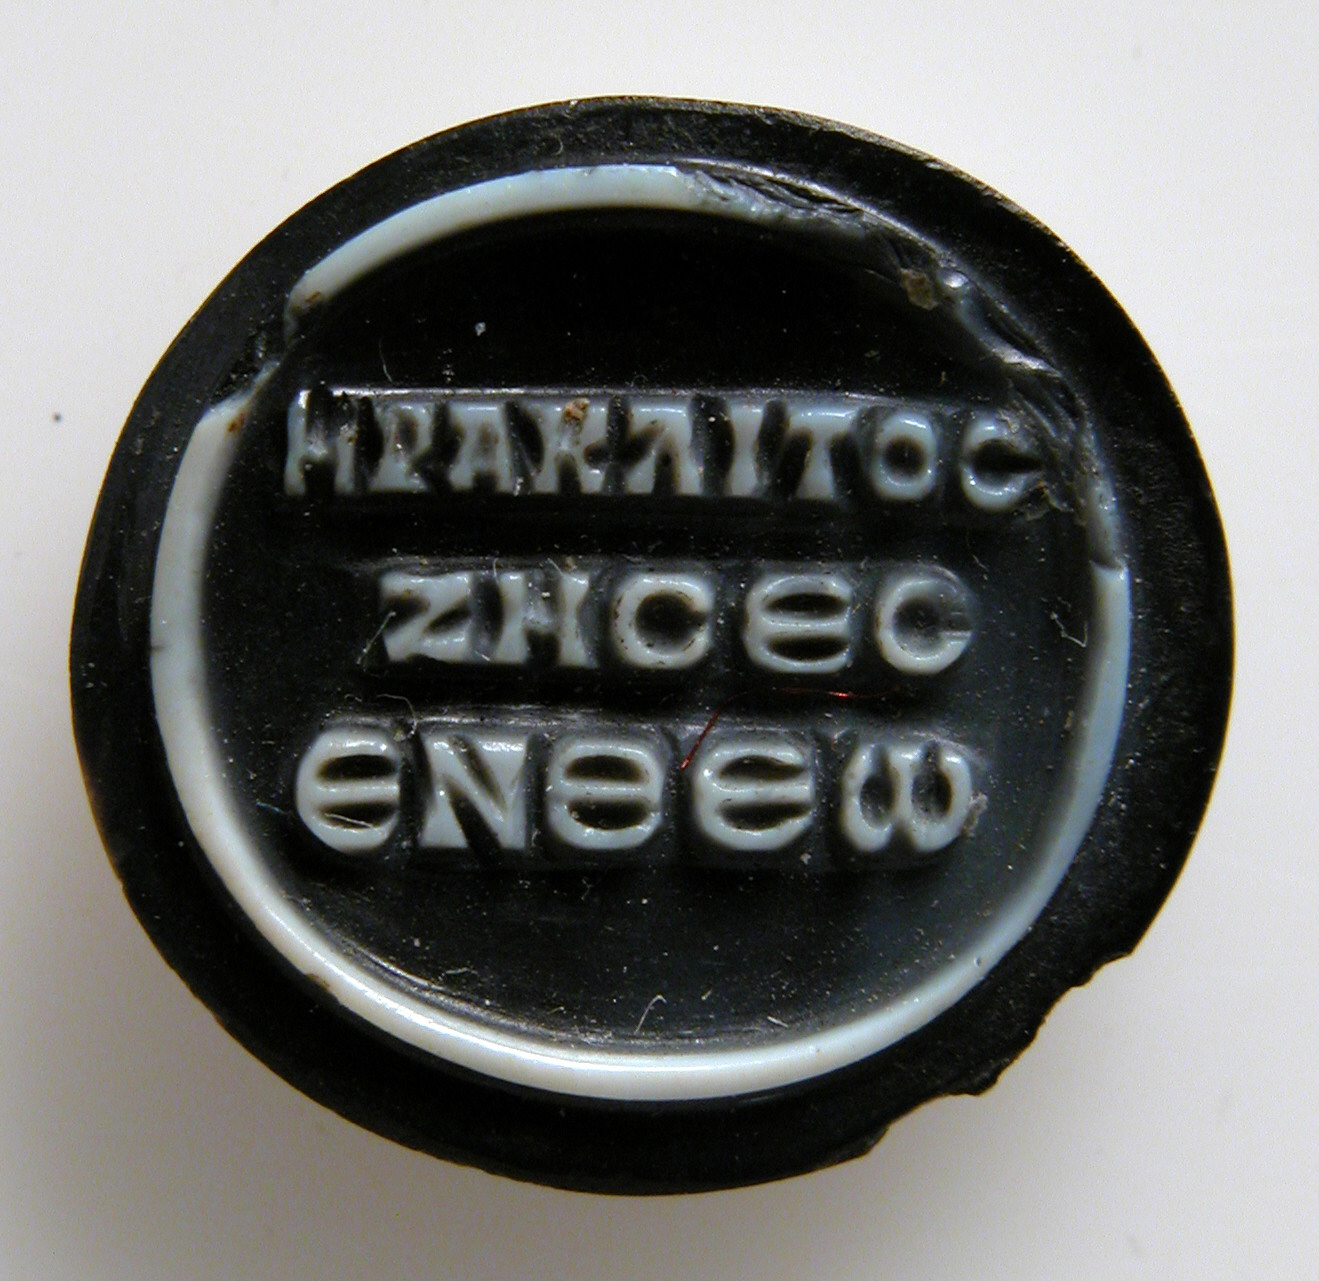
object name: gem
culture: roman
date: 101-400